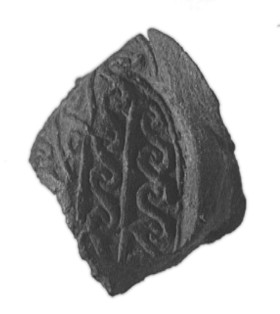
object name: sealing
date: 2030-1640 BCE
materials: clay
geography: egypt